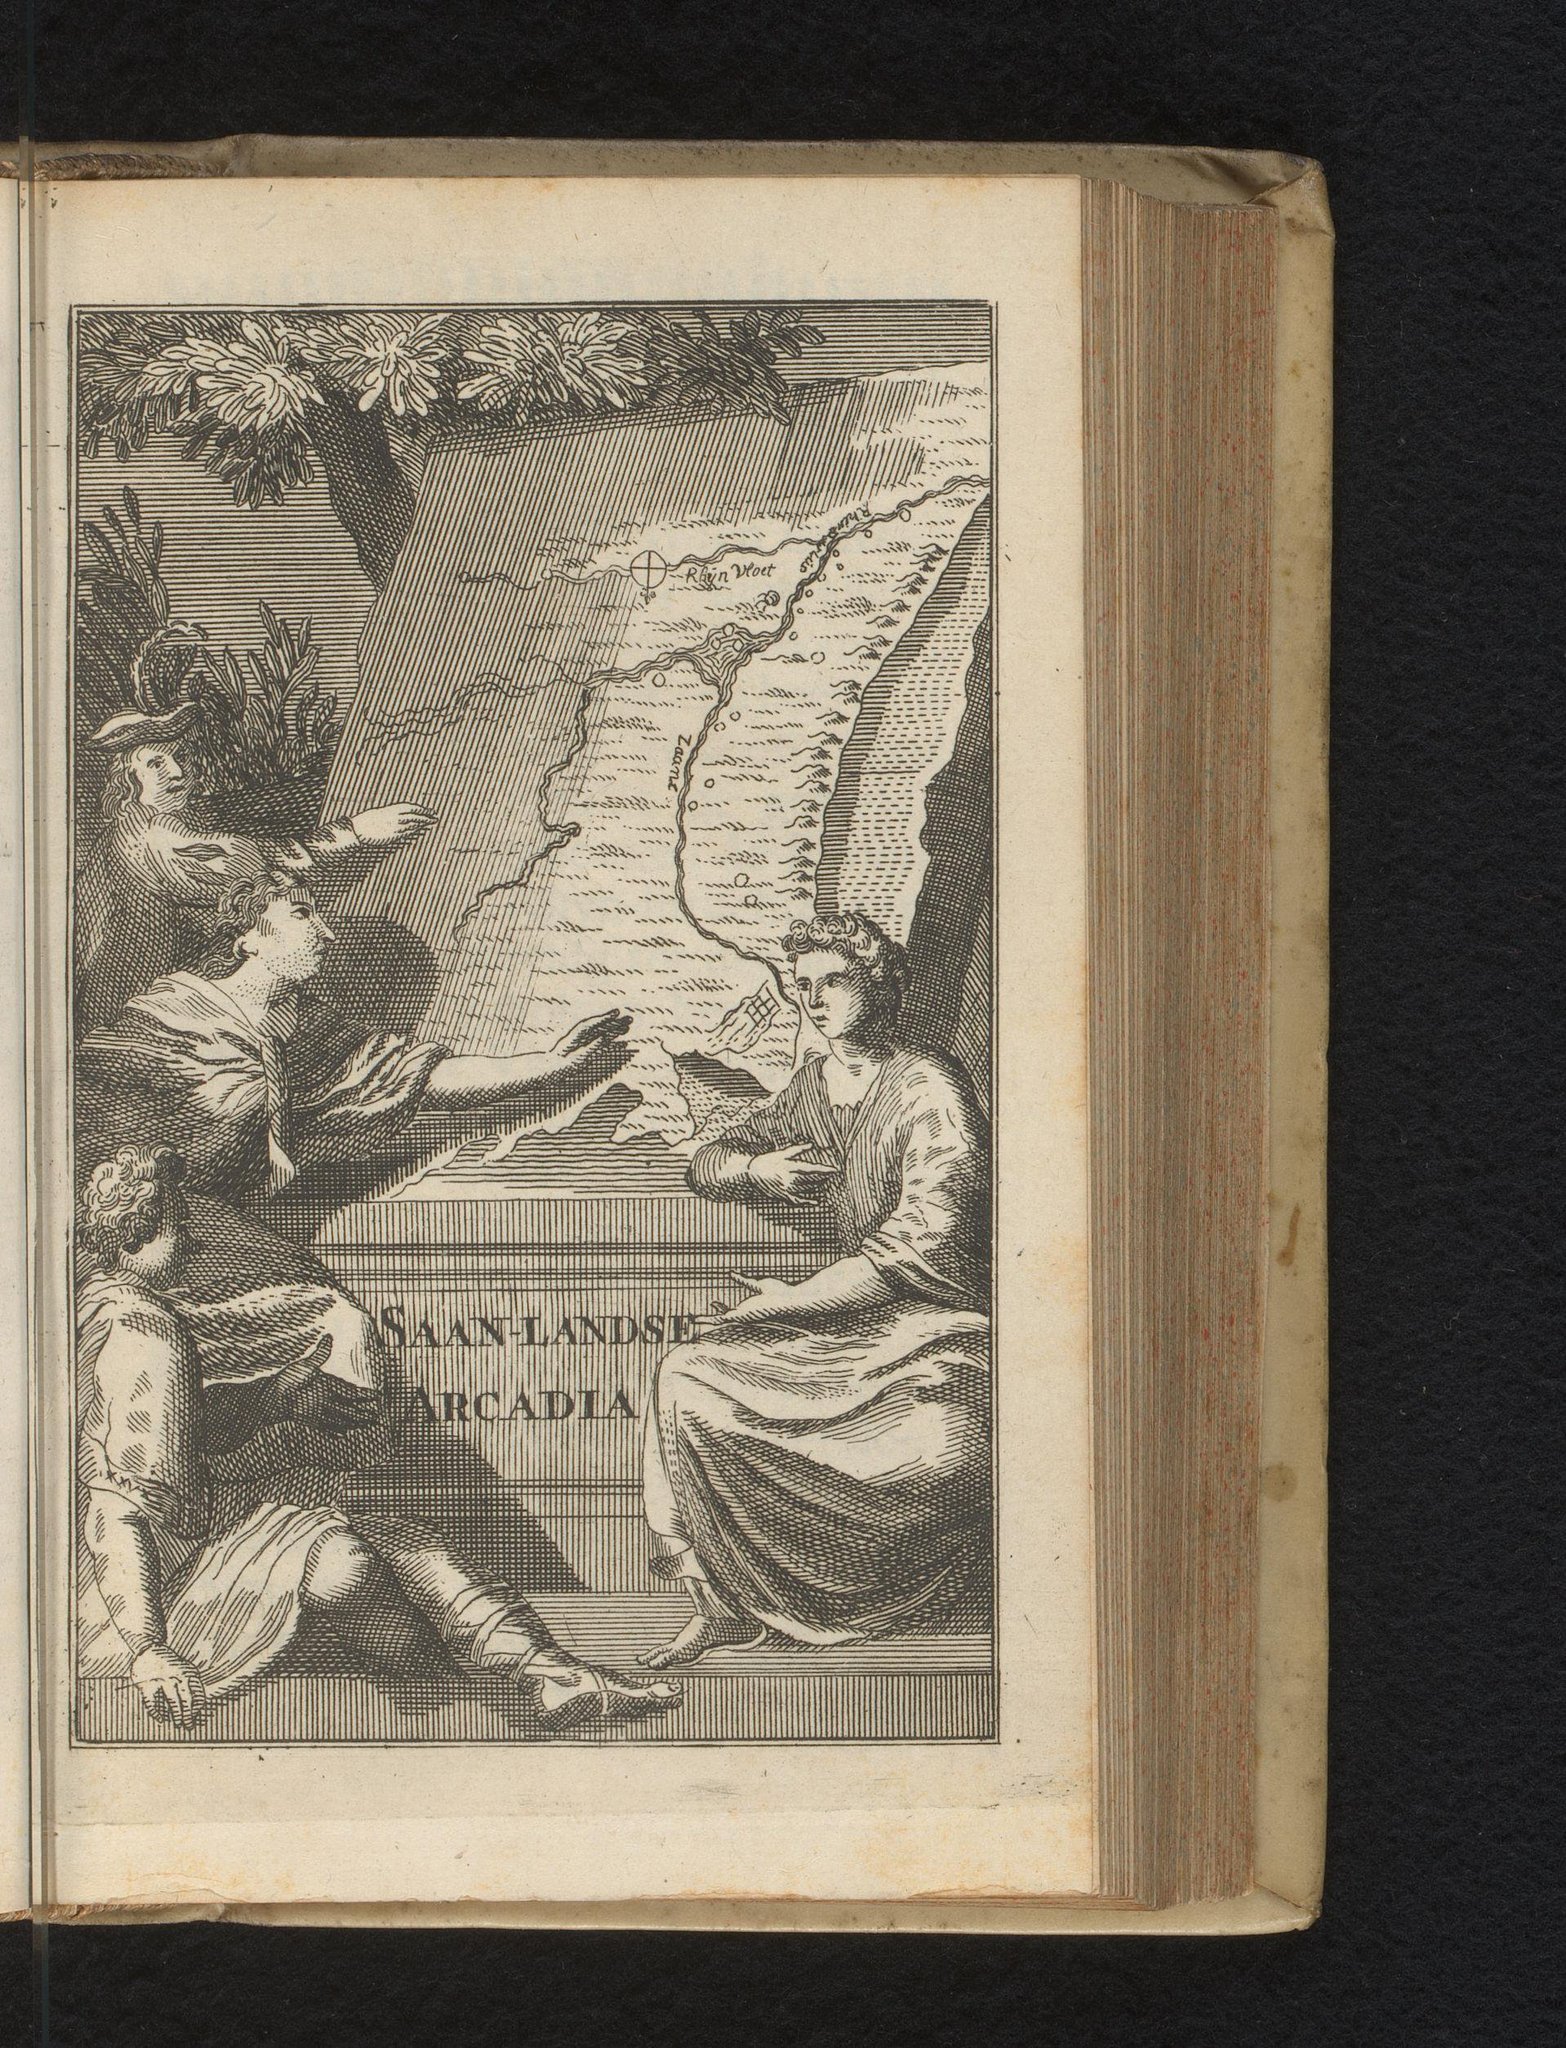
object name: titelprent, frontispice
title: Titelprent voor Saan-Landse Arcadia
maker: pieter van den berge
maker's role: draughtsman, print maker, printer, publisher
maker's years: 1659-1737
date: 1700-1702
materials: paper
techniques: etching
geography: northern netherlands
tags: zaanstreek, nederland tijdens de late middeleeuwen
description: Illustratie in: H. Soeteboom, Oud-heden van Zaan-land, Stavoren, Vronen en Waterland : deze laatste druk ... met nodige aanteekeningen, figuren, en een landkaart verrykt, W. Linnig van Koppenol, Amsterdam 1702, dl. 1, titelprent.